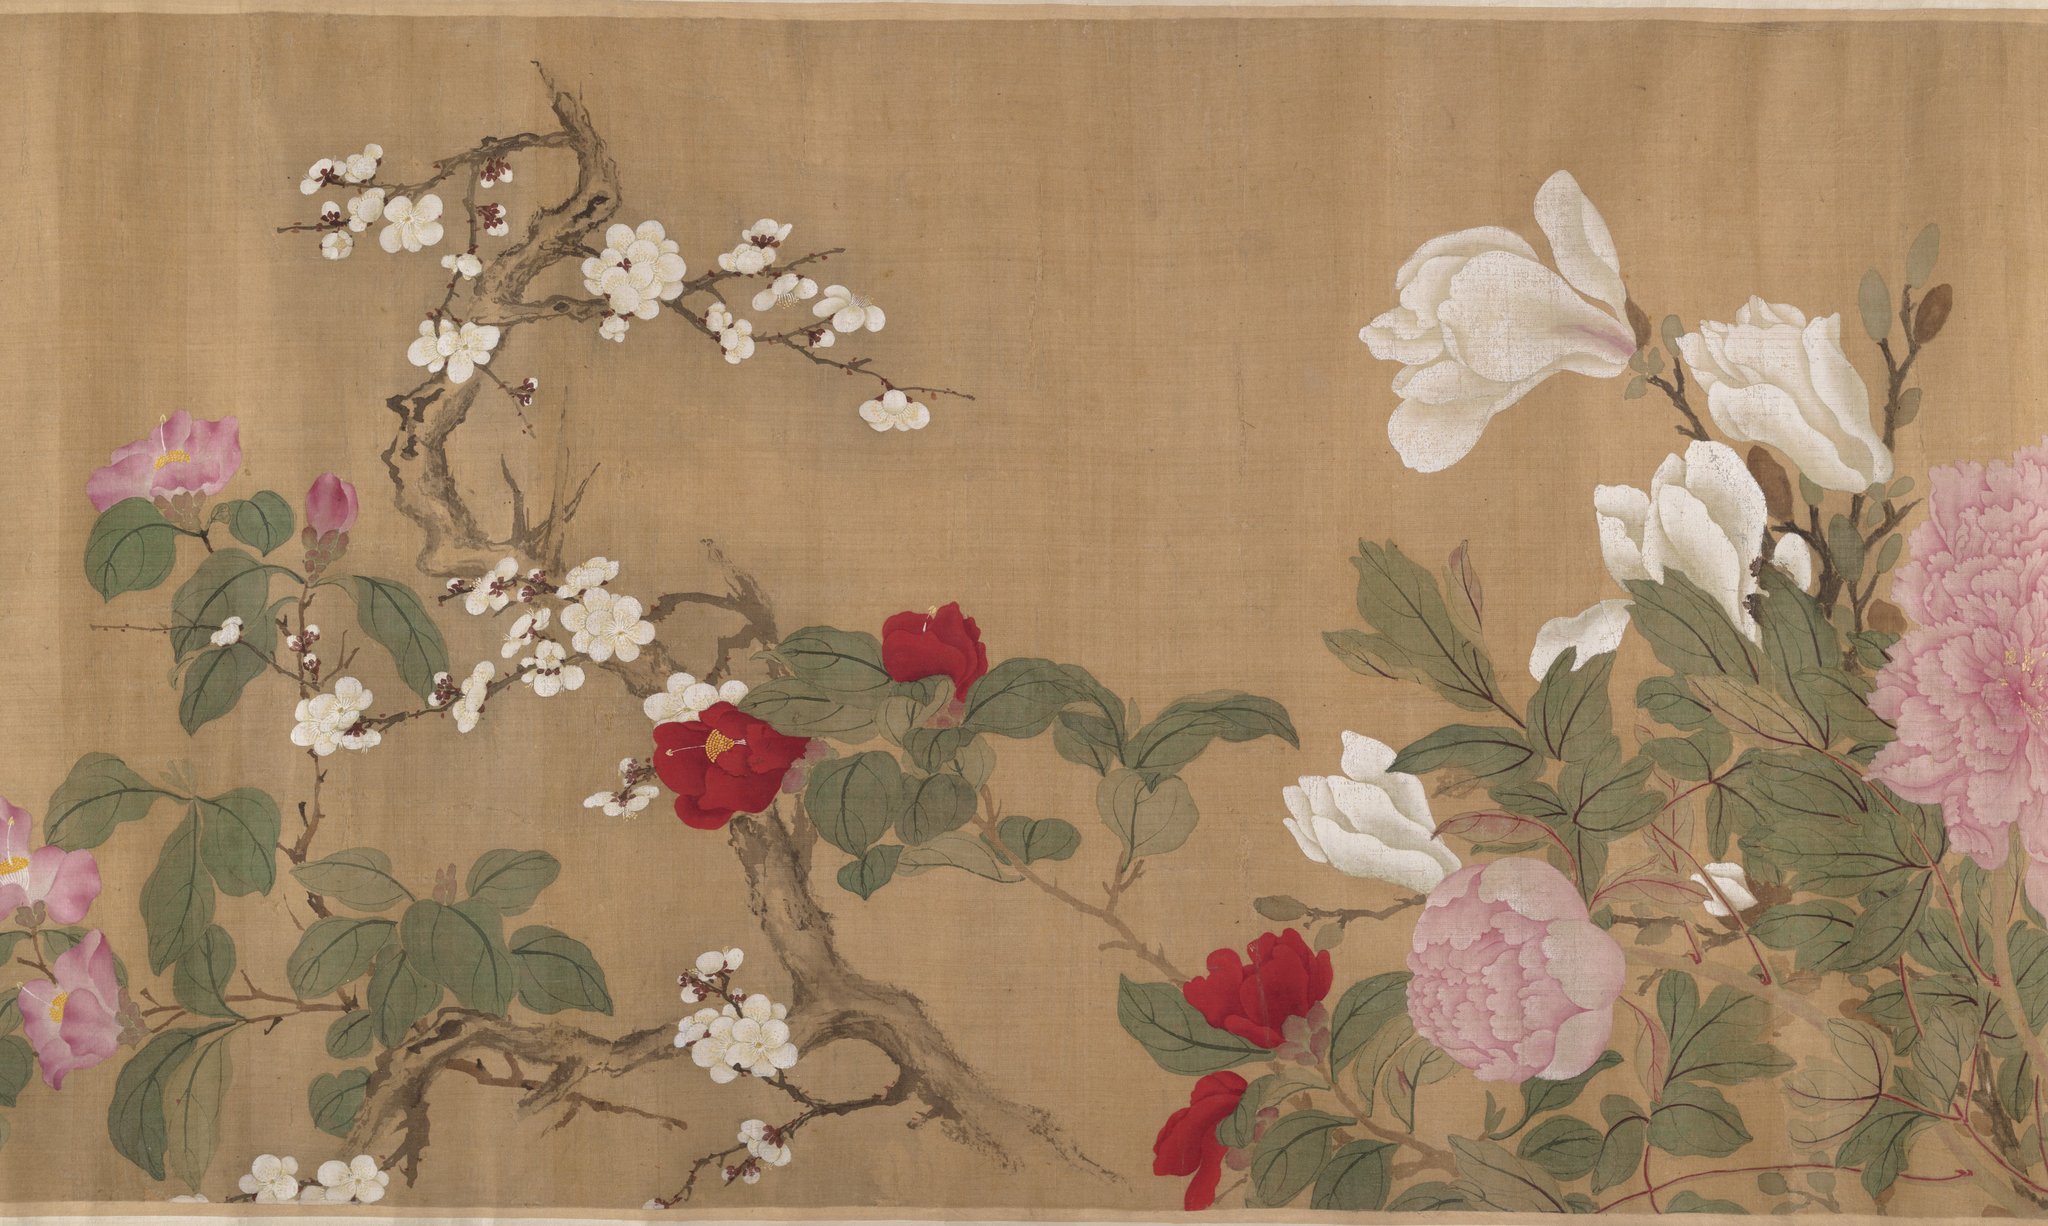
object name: handscroll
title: One Hundred Flowers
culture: chinese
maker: yun shouping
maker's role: artist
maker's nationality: chinese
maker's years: 1633-1690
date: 1701-1800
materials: ink, silk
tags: flowers